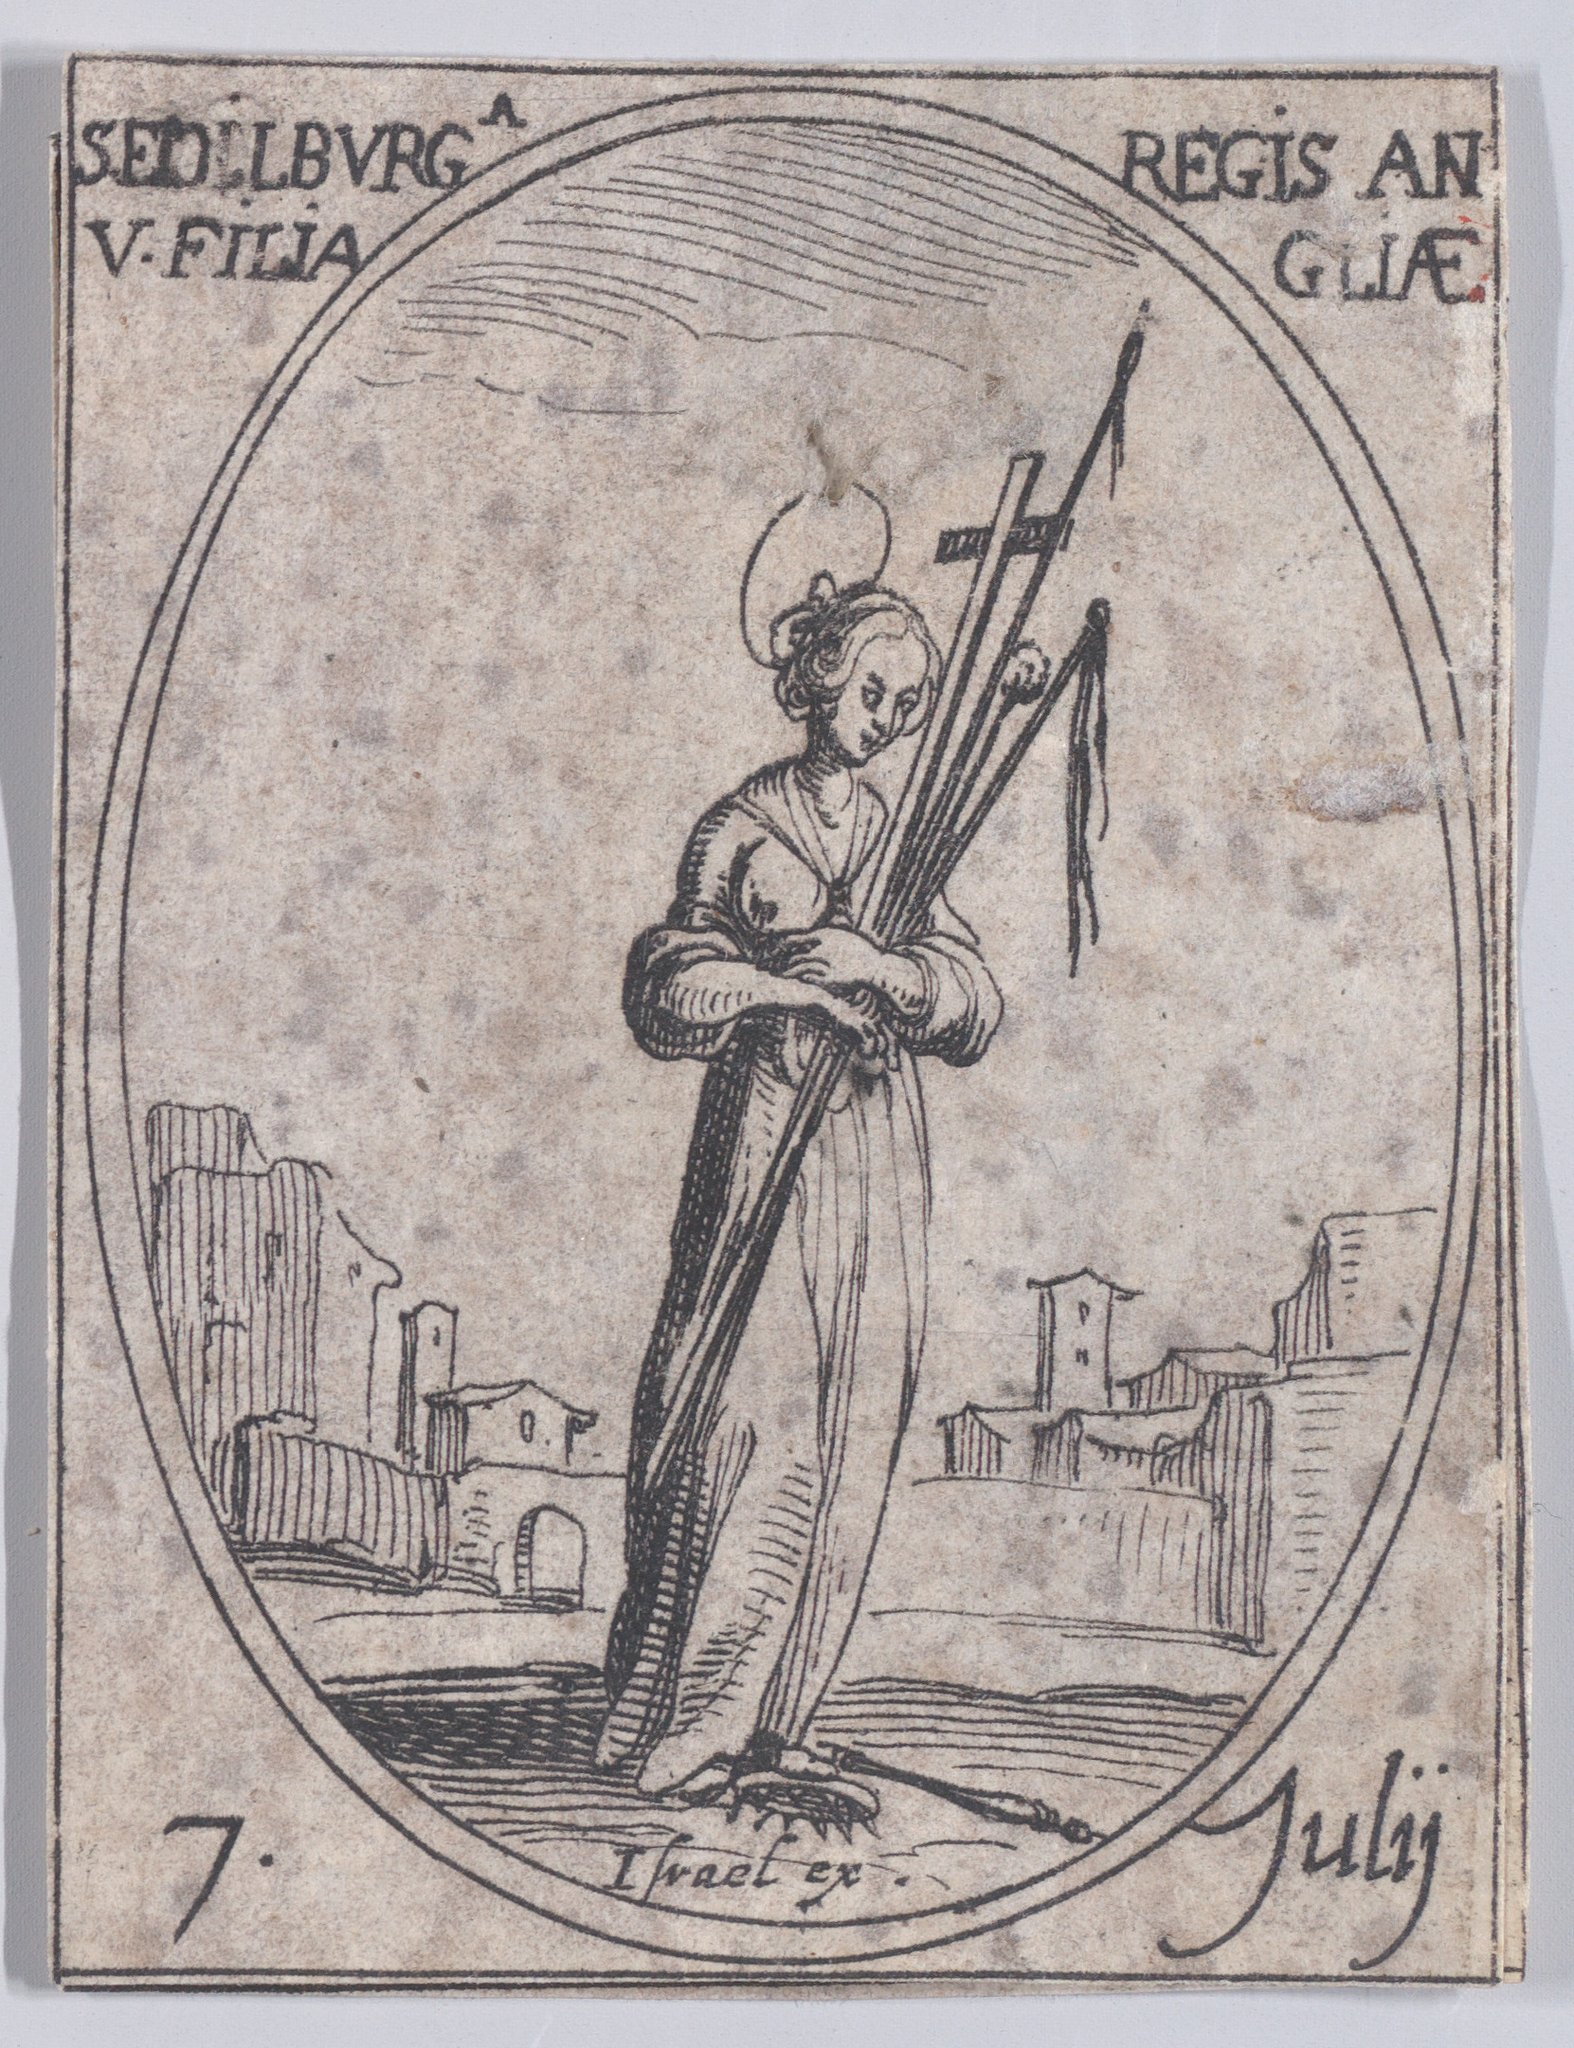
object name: print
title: Ste. Edilburge, fille du roi d'Angleterre (St. Ethelburga, Daughter of the King of England), July 7th, from "Les Images De Tous Les Saincts et Saintes de L'Année" (Images of All of the Saints and Religious Events of the Year)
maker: jacques callot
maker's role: artist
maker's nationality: french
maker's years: 1592-1635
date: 1636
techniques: etching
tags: women,saints